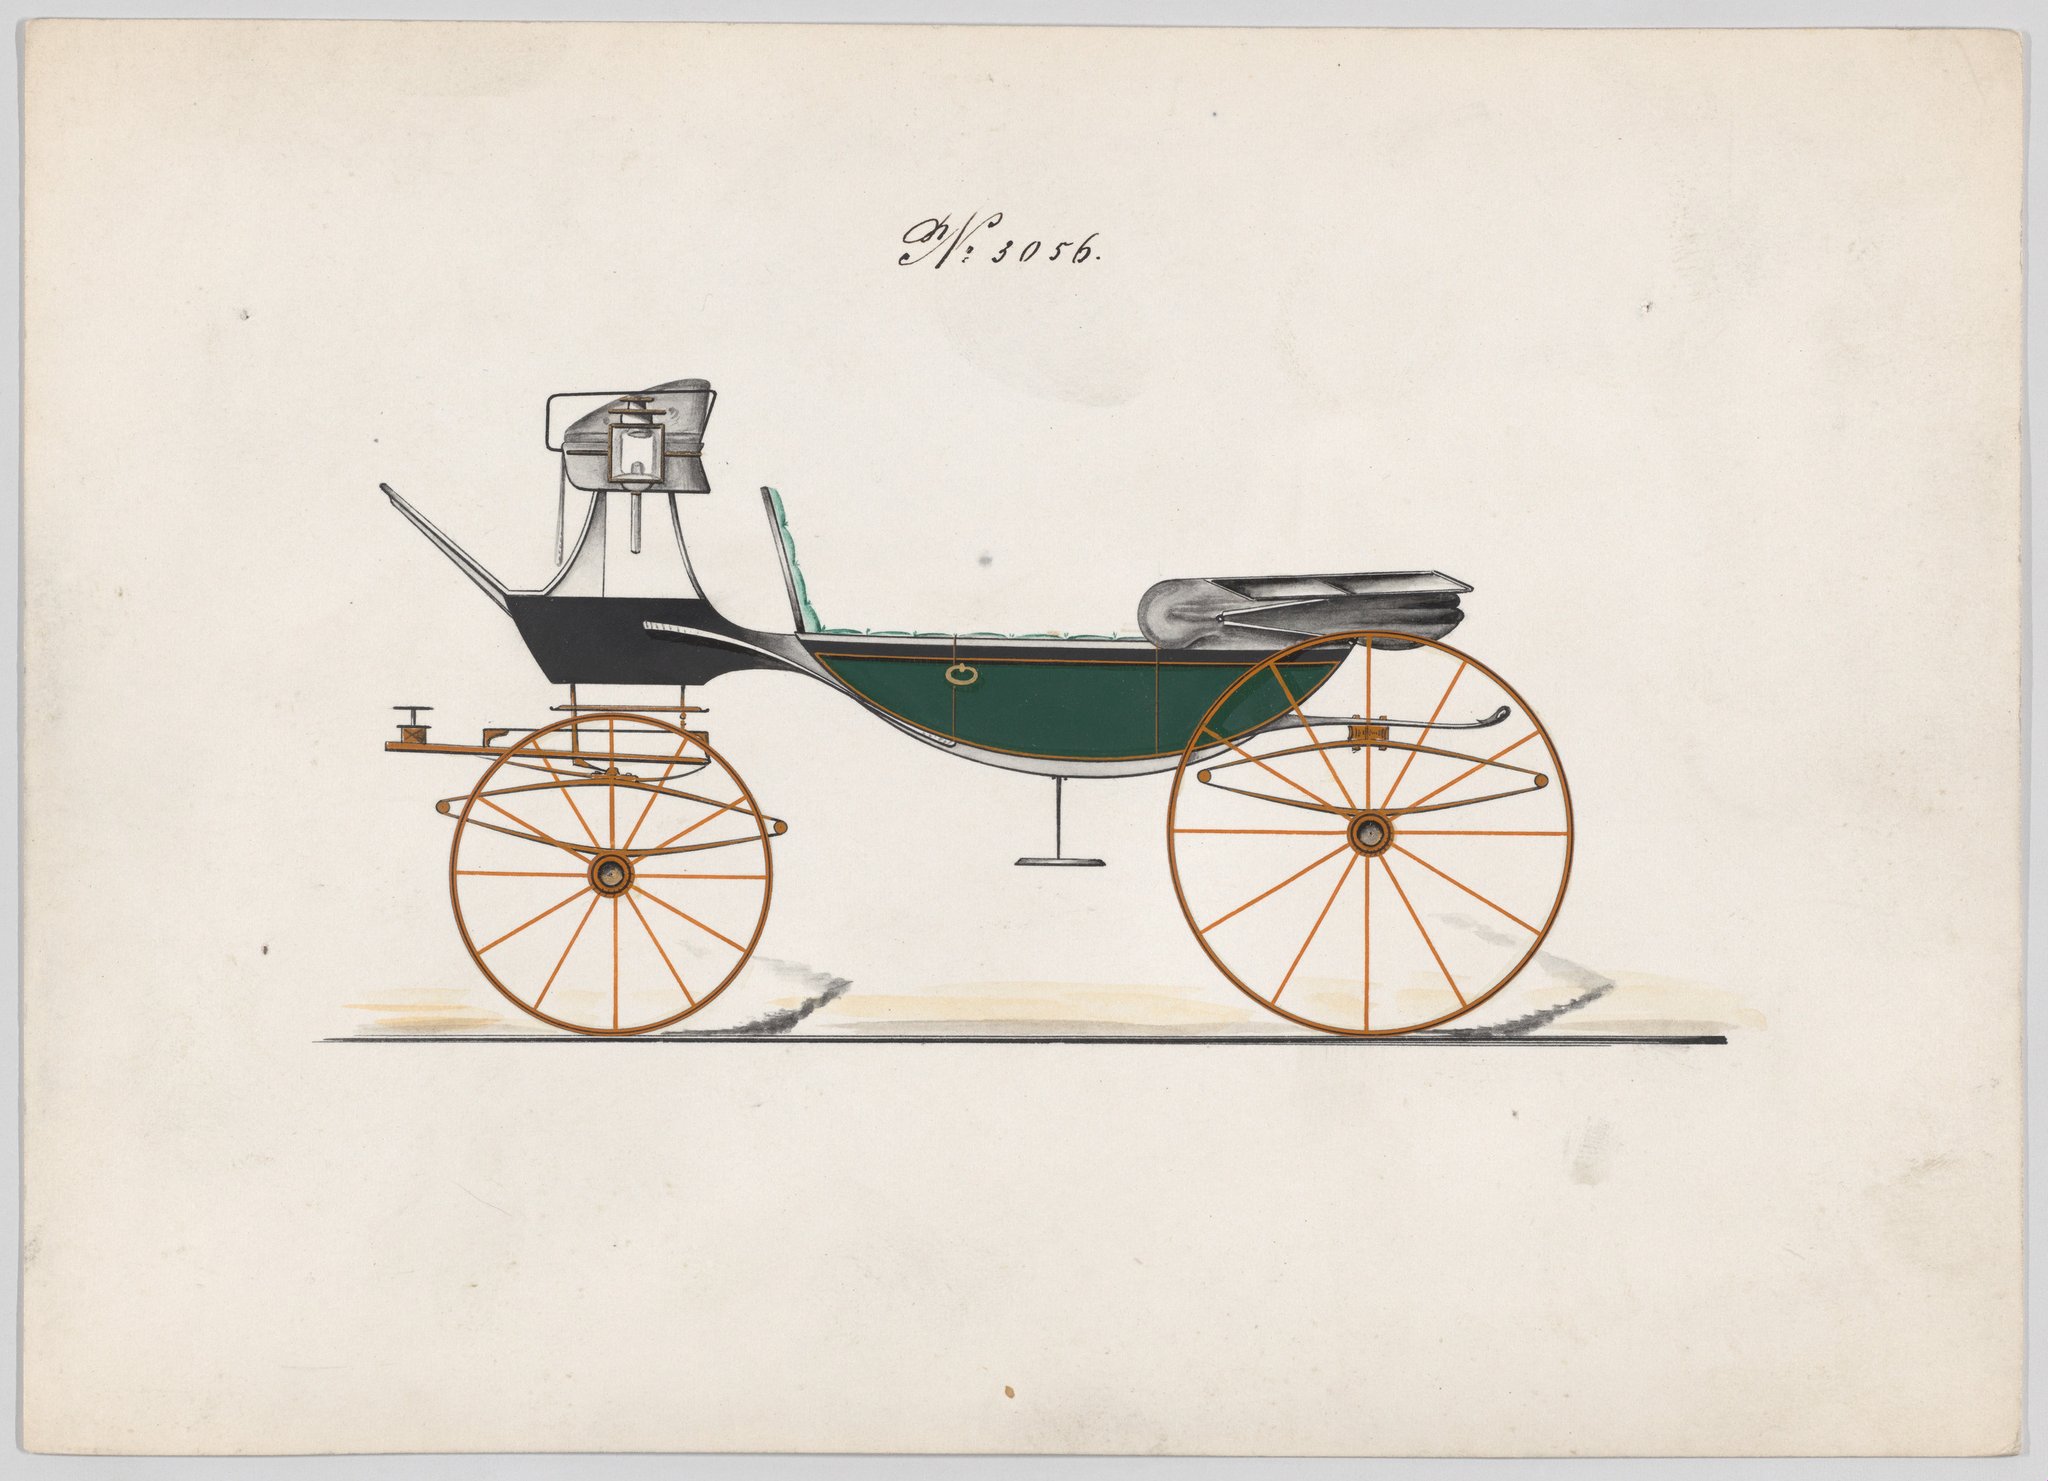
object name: drawing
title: Vis-à-vis #3056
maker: brewster & co.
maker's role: manufacturer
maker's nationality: american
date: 1874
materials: gouache, gum arabic, ink, watercolor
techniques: pen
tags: carriages